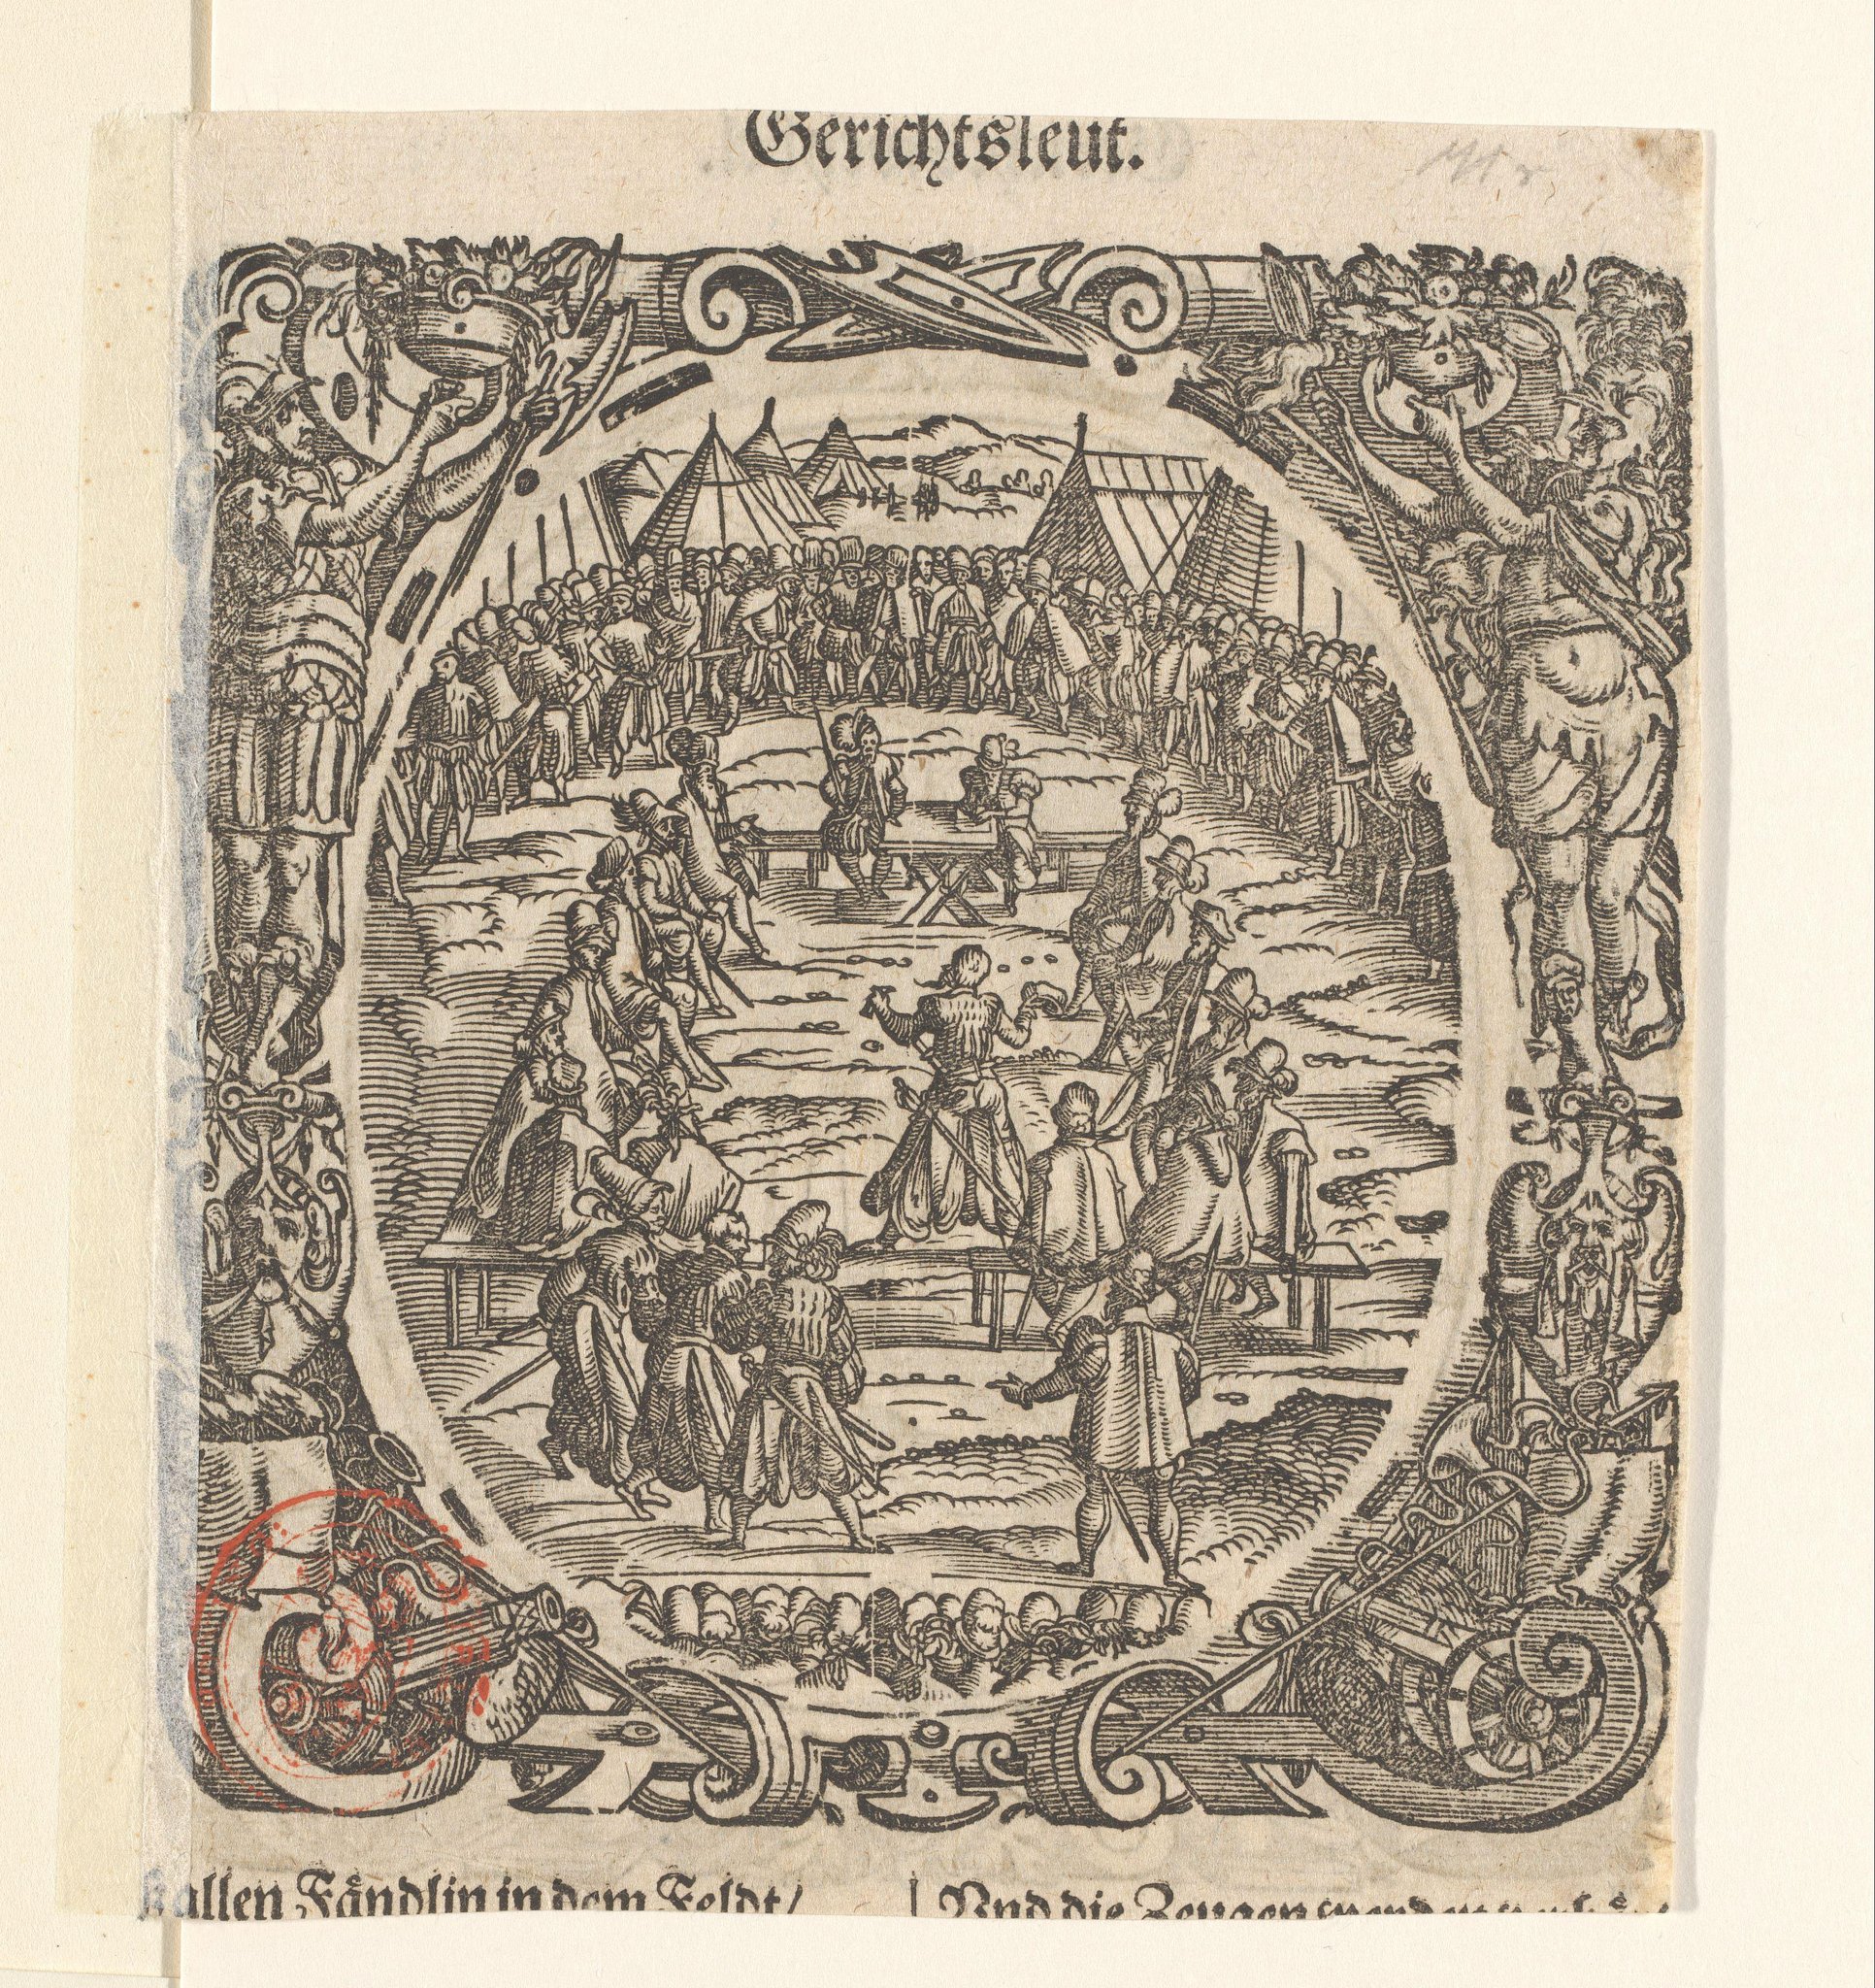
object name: print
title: Zitting van de krijgsraad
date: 1573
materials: paper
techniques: woodcut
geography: frankfurt am main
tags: (military) camp with tents, warfare; military affairs, the soldier; the soldier's life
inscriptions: collector's mark: Lugt 240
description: Zowel de voorstelling als de ornamentrand werd gebruikt voor verschillende edities van Leonhardt Fronspergers Kriegsbuch.